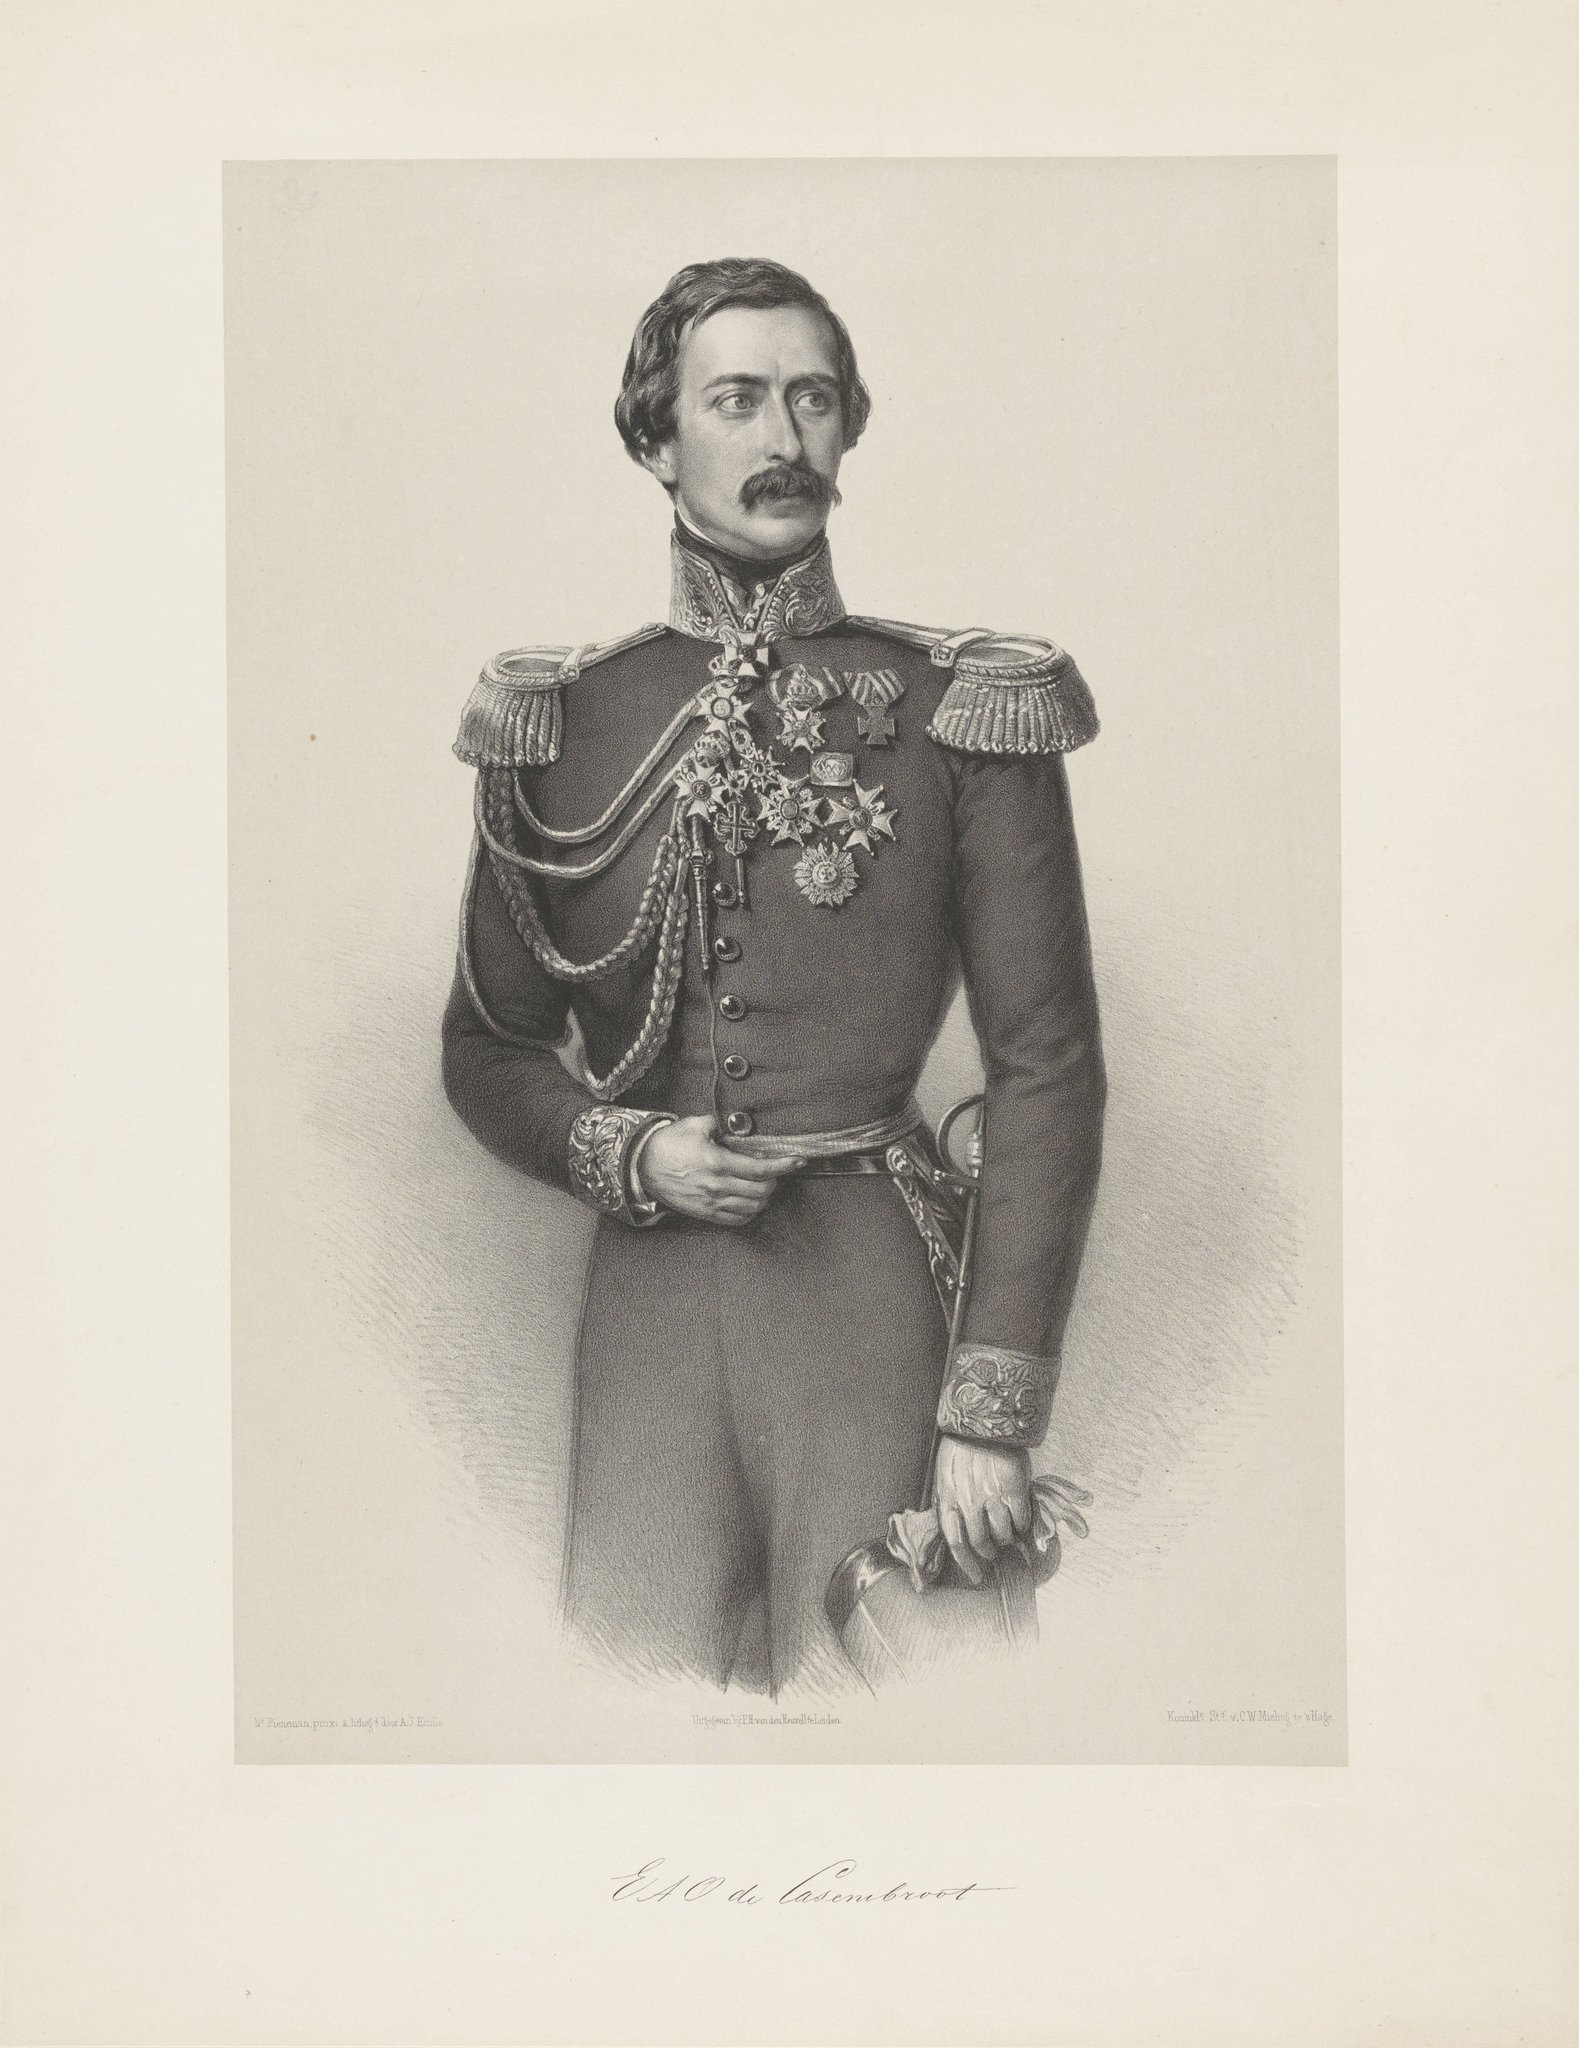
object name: print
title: Portret van Eduard August Otto de Casembroot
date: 1857-1863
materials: paper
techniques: lithograph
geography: leiden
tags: eduard august otto de casembroot, knighthood order, hacking and thrusting weapons (with name), historical persons (+ three-quarter length portrait)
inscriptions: collector's mark: Lugt 2228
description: De geportretteerde draagt een militair uniform en kijkt naar rechts. Met zijn rechterhand houdt hij zijn riem vast, in zijn linkerhand heeft hij zijn handschoenen en kepi. Op zijn borst draagt hij onderscheidingen en aan zijn riem hangt een sabel. Onder het portret zijn signatuur.